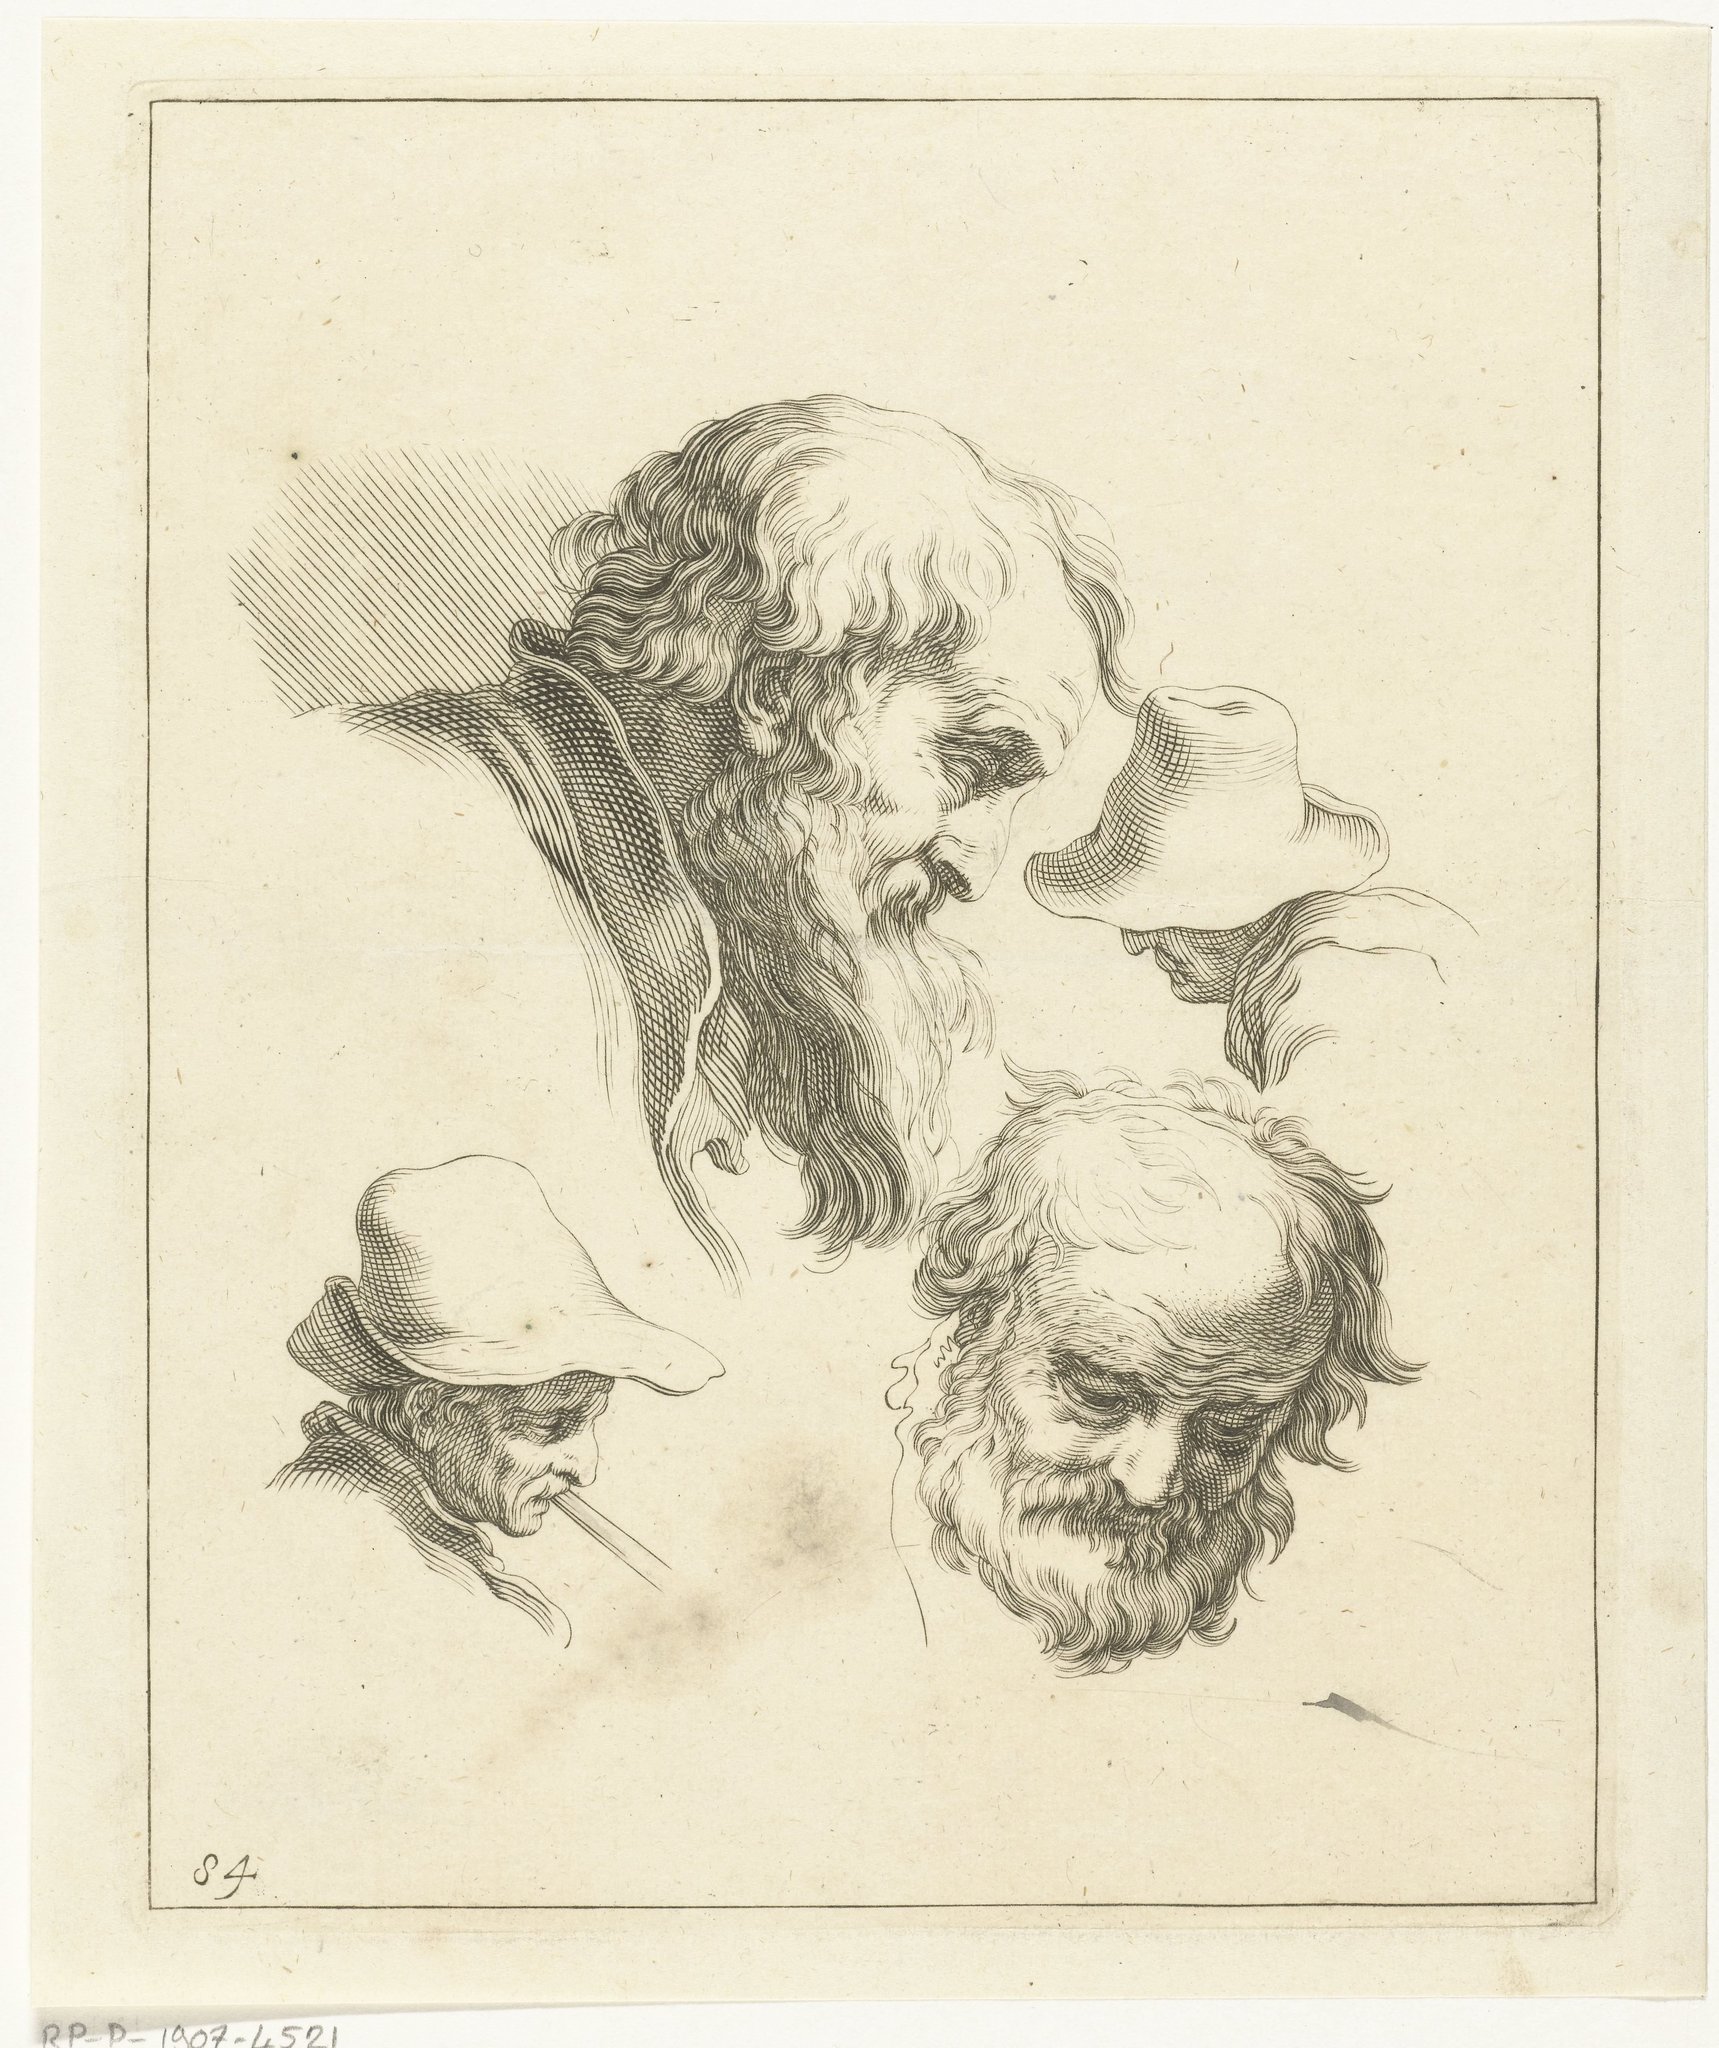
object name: print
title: Het tekenboek van Abraham Bloemaert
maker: frederick bloemaert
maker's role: print maker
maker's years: 1614-1669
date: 1679-1701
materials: paper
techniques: engraving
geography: utrecht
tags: head (human)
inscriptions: collector's mark: Lugt 2228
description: Hetzelfde watermerk als de titelpagina van de Visscher editie.